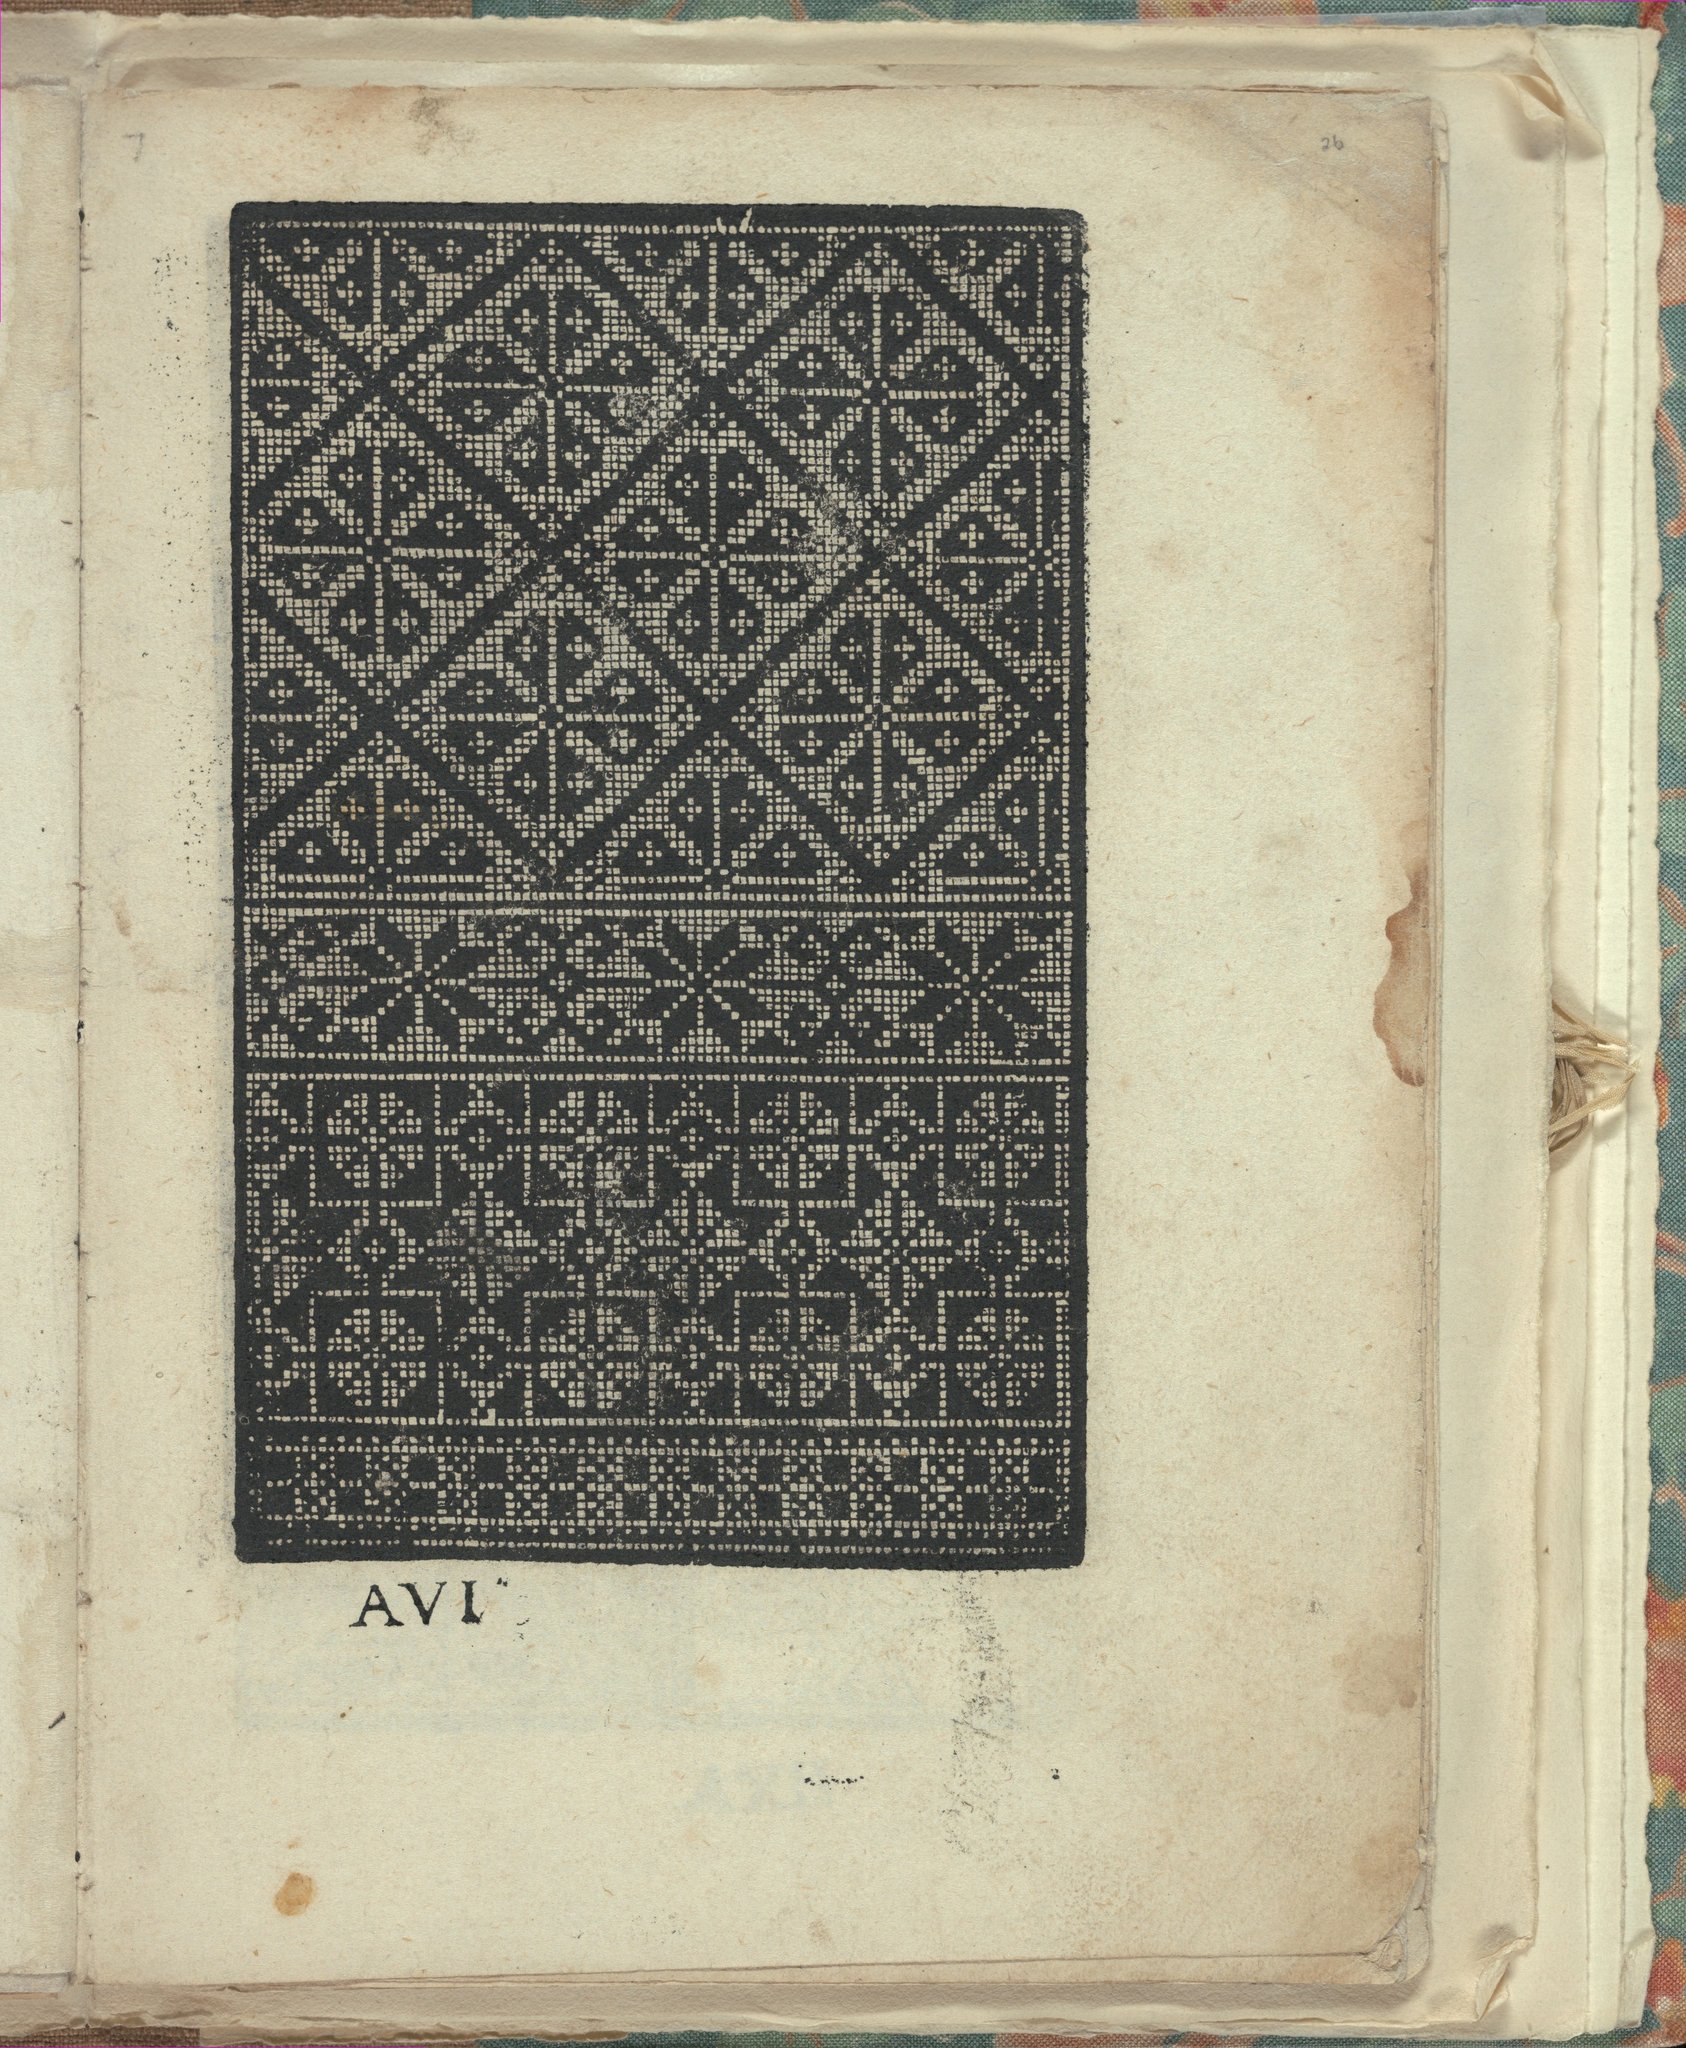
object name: book print ornament architecture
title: Opera Nova Universali intitulata Corona di racammi, page 26 (recto)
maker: giovanni andrea vavassore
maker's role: publisher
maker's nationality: italian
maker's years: 1530-1573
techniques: woodcut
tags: ornament